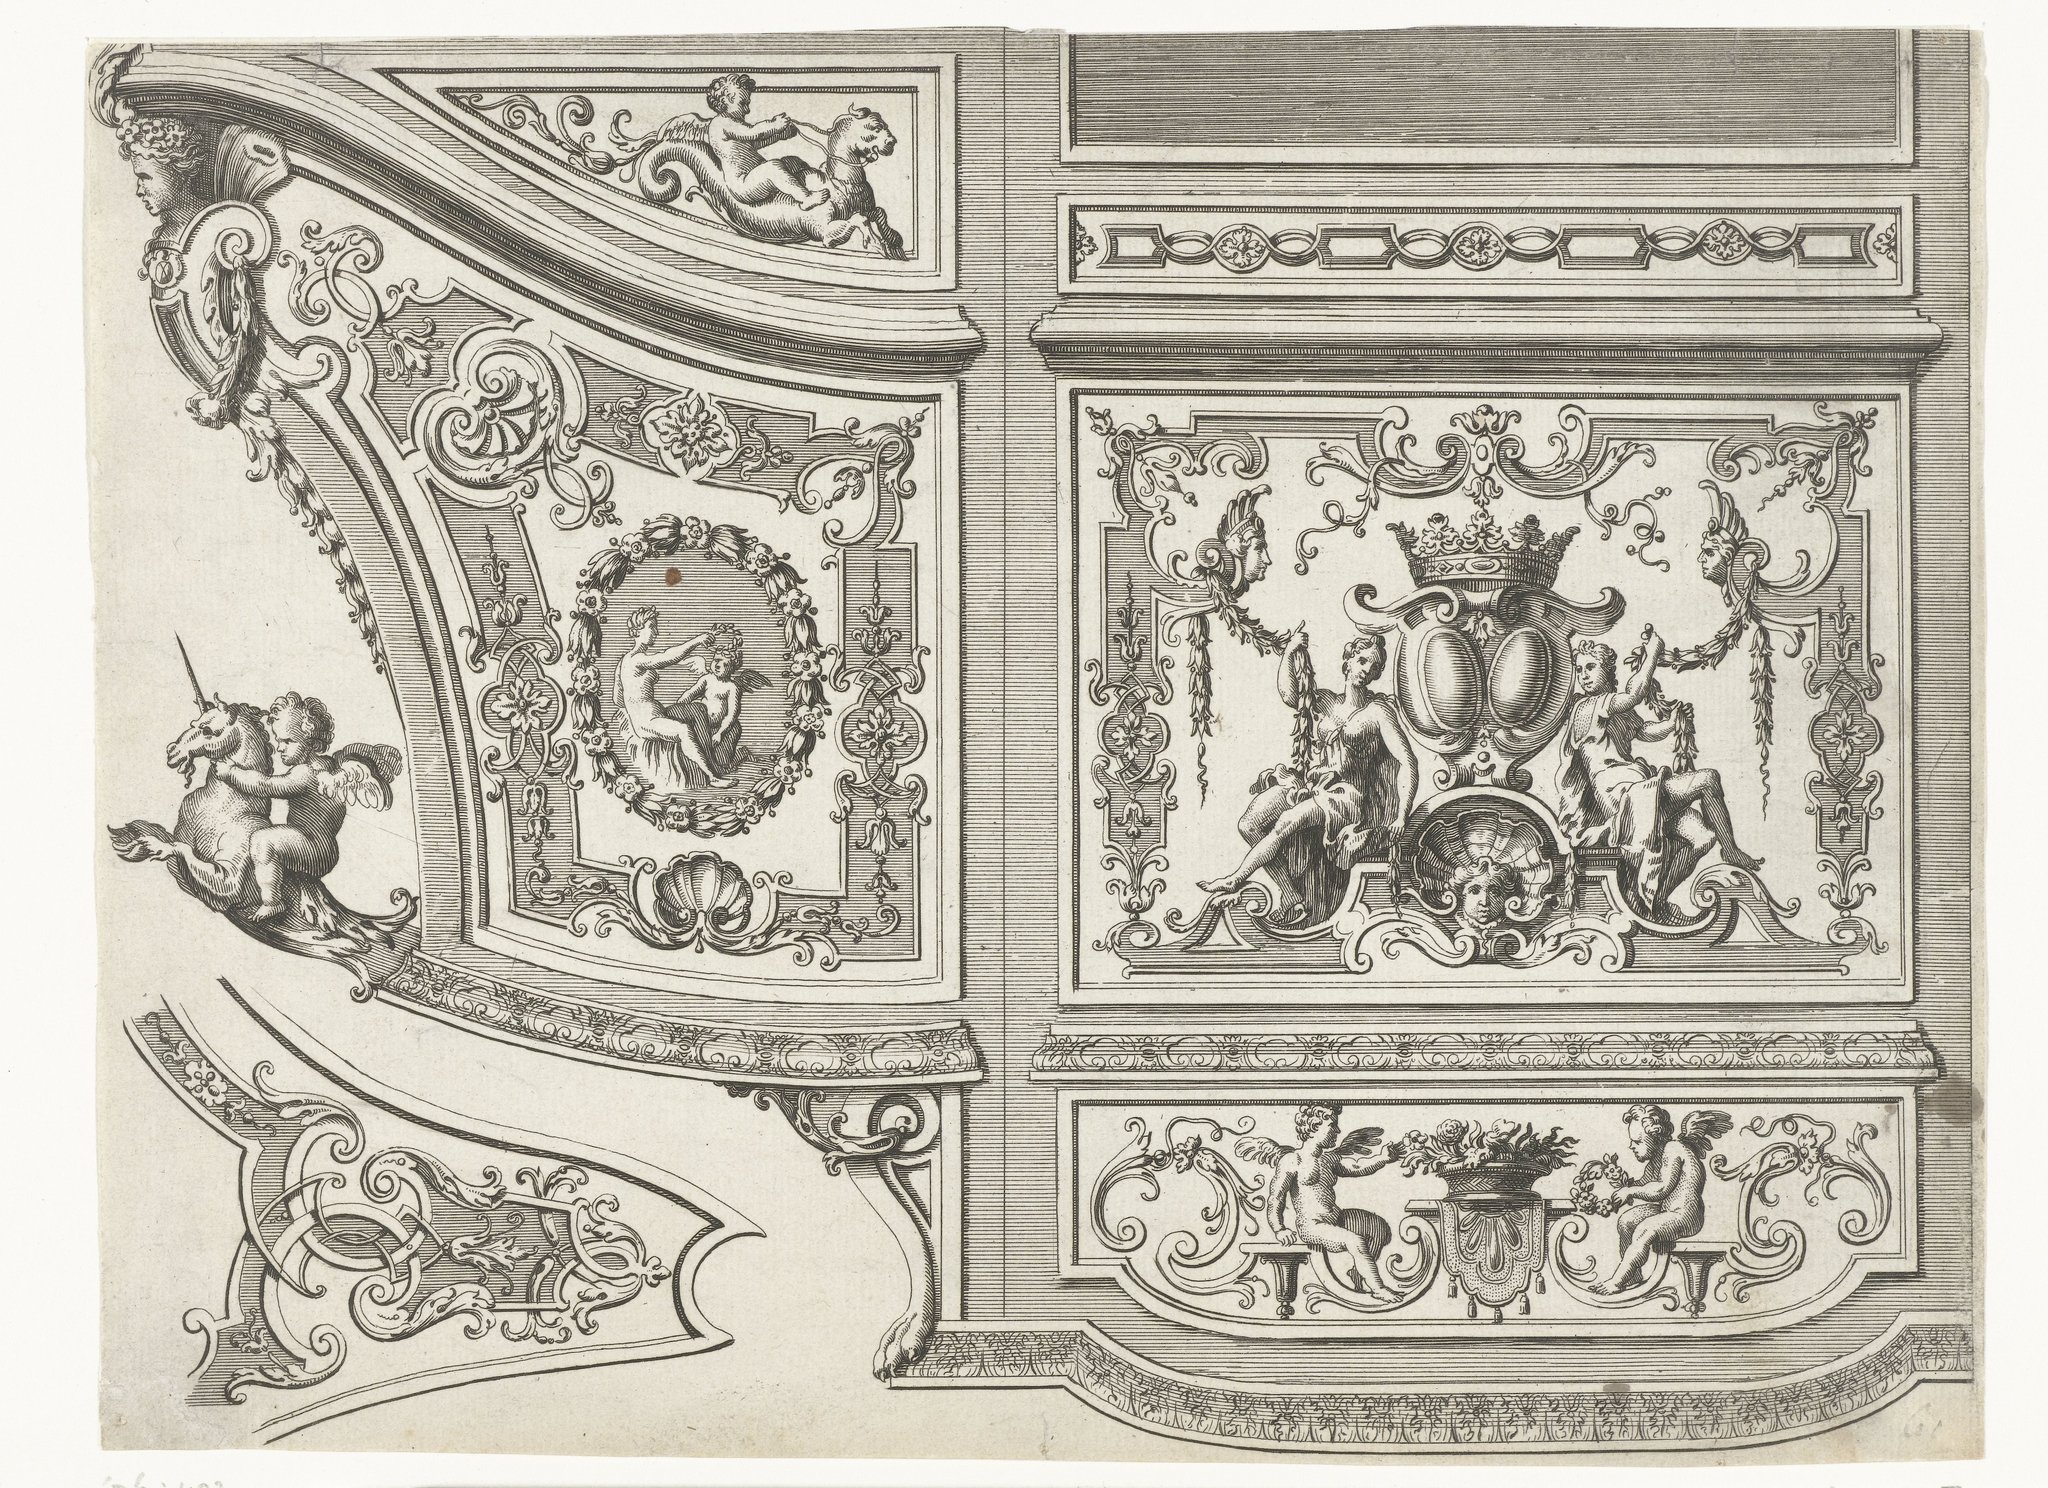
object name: ornament print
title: Panelen met grotesken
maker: moritz bodenehr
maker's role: print maker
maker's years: 1665-1749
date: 1675-1748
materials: paper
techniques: engraving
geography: germany